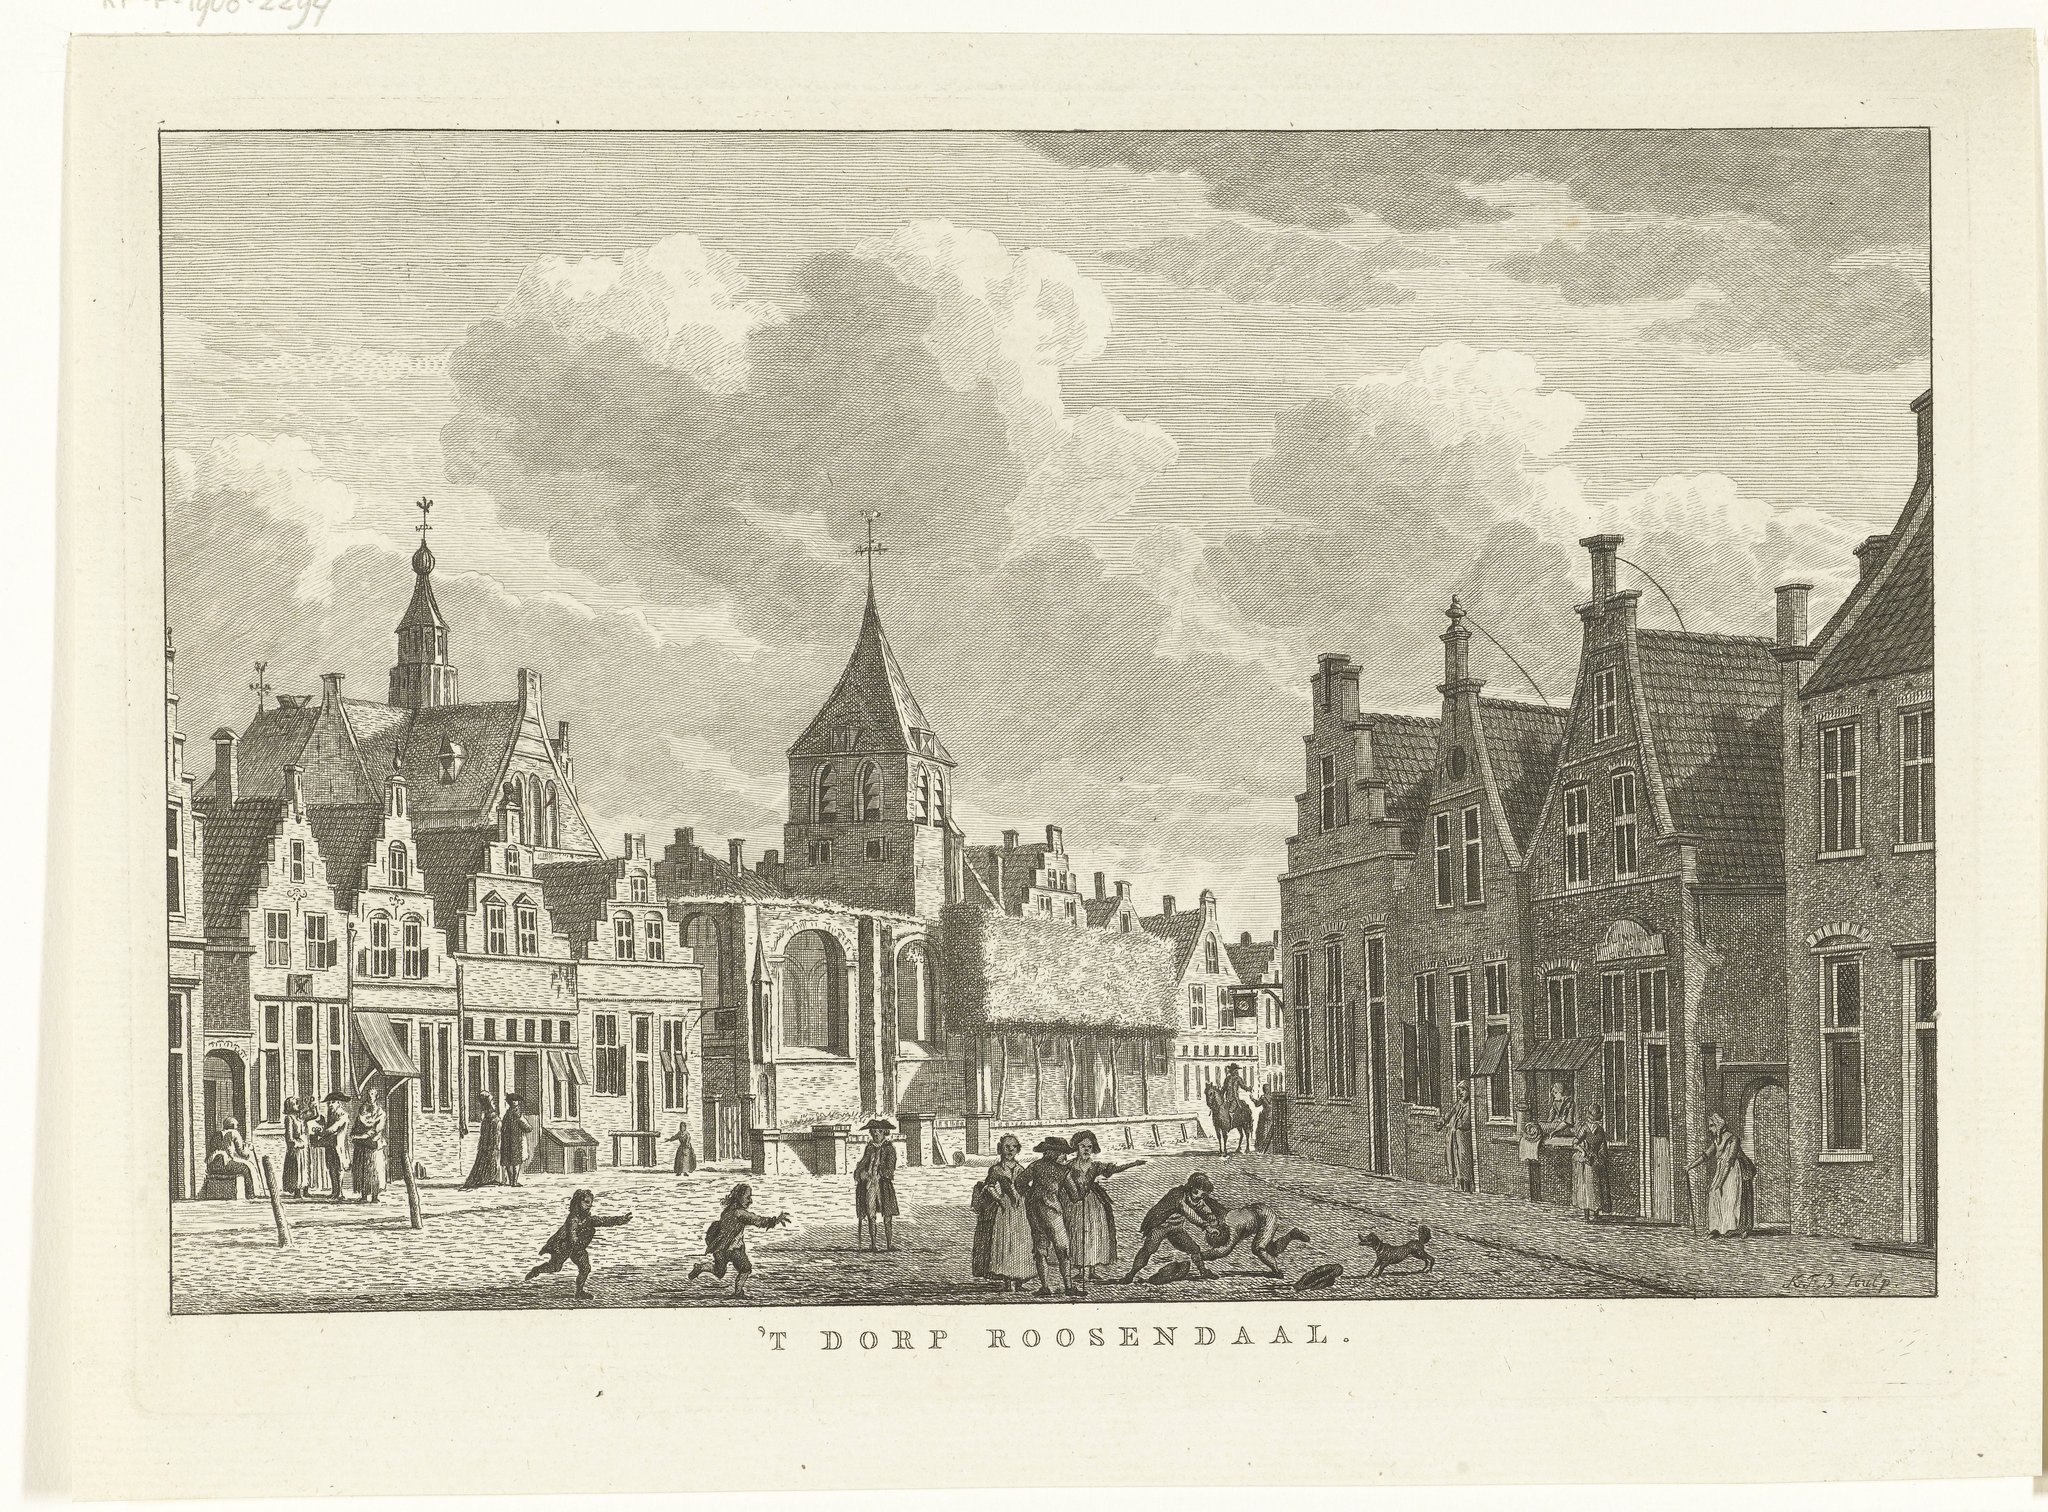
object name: print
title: Stadsgezicht te Roosendaal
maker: carel frederik bendorp (i)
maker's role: print maker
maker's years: 1736-1814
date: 1786-1792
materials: paper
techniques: etching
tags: city-view in general; 'veduta'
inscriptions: collector's mark: Lugt 2228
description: Prent uit: Vaderlandsche gezichten, of afbeeldingen van den tegenwoordigen staat der Vereenigde Nederlanden (…). Amsterdam: Hendrik Gartman, Willem Vermandel en Jan Willem Smit, 1786-1792. Uitgegeven in afleveringen met ieder een eigen bifolium en inhoudsopgave. Alle prenten in deze publicatie zijn gegraveerd door Carel Frederik Bendorp (I) en, in de meeste gevallen, gebaseerd op tekeningen van Jan Bulthuis.